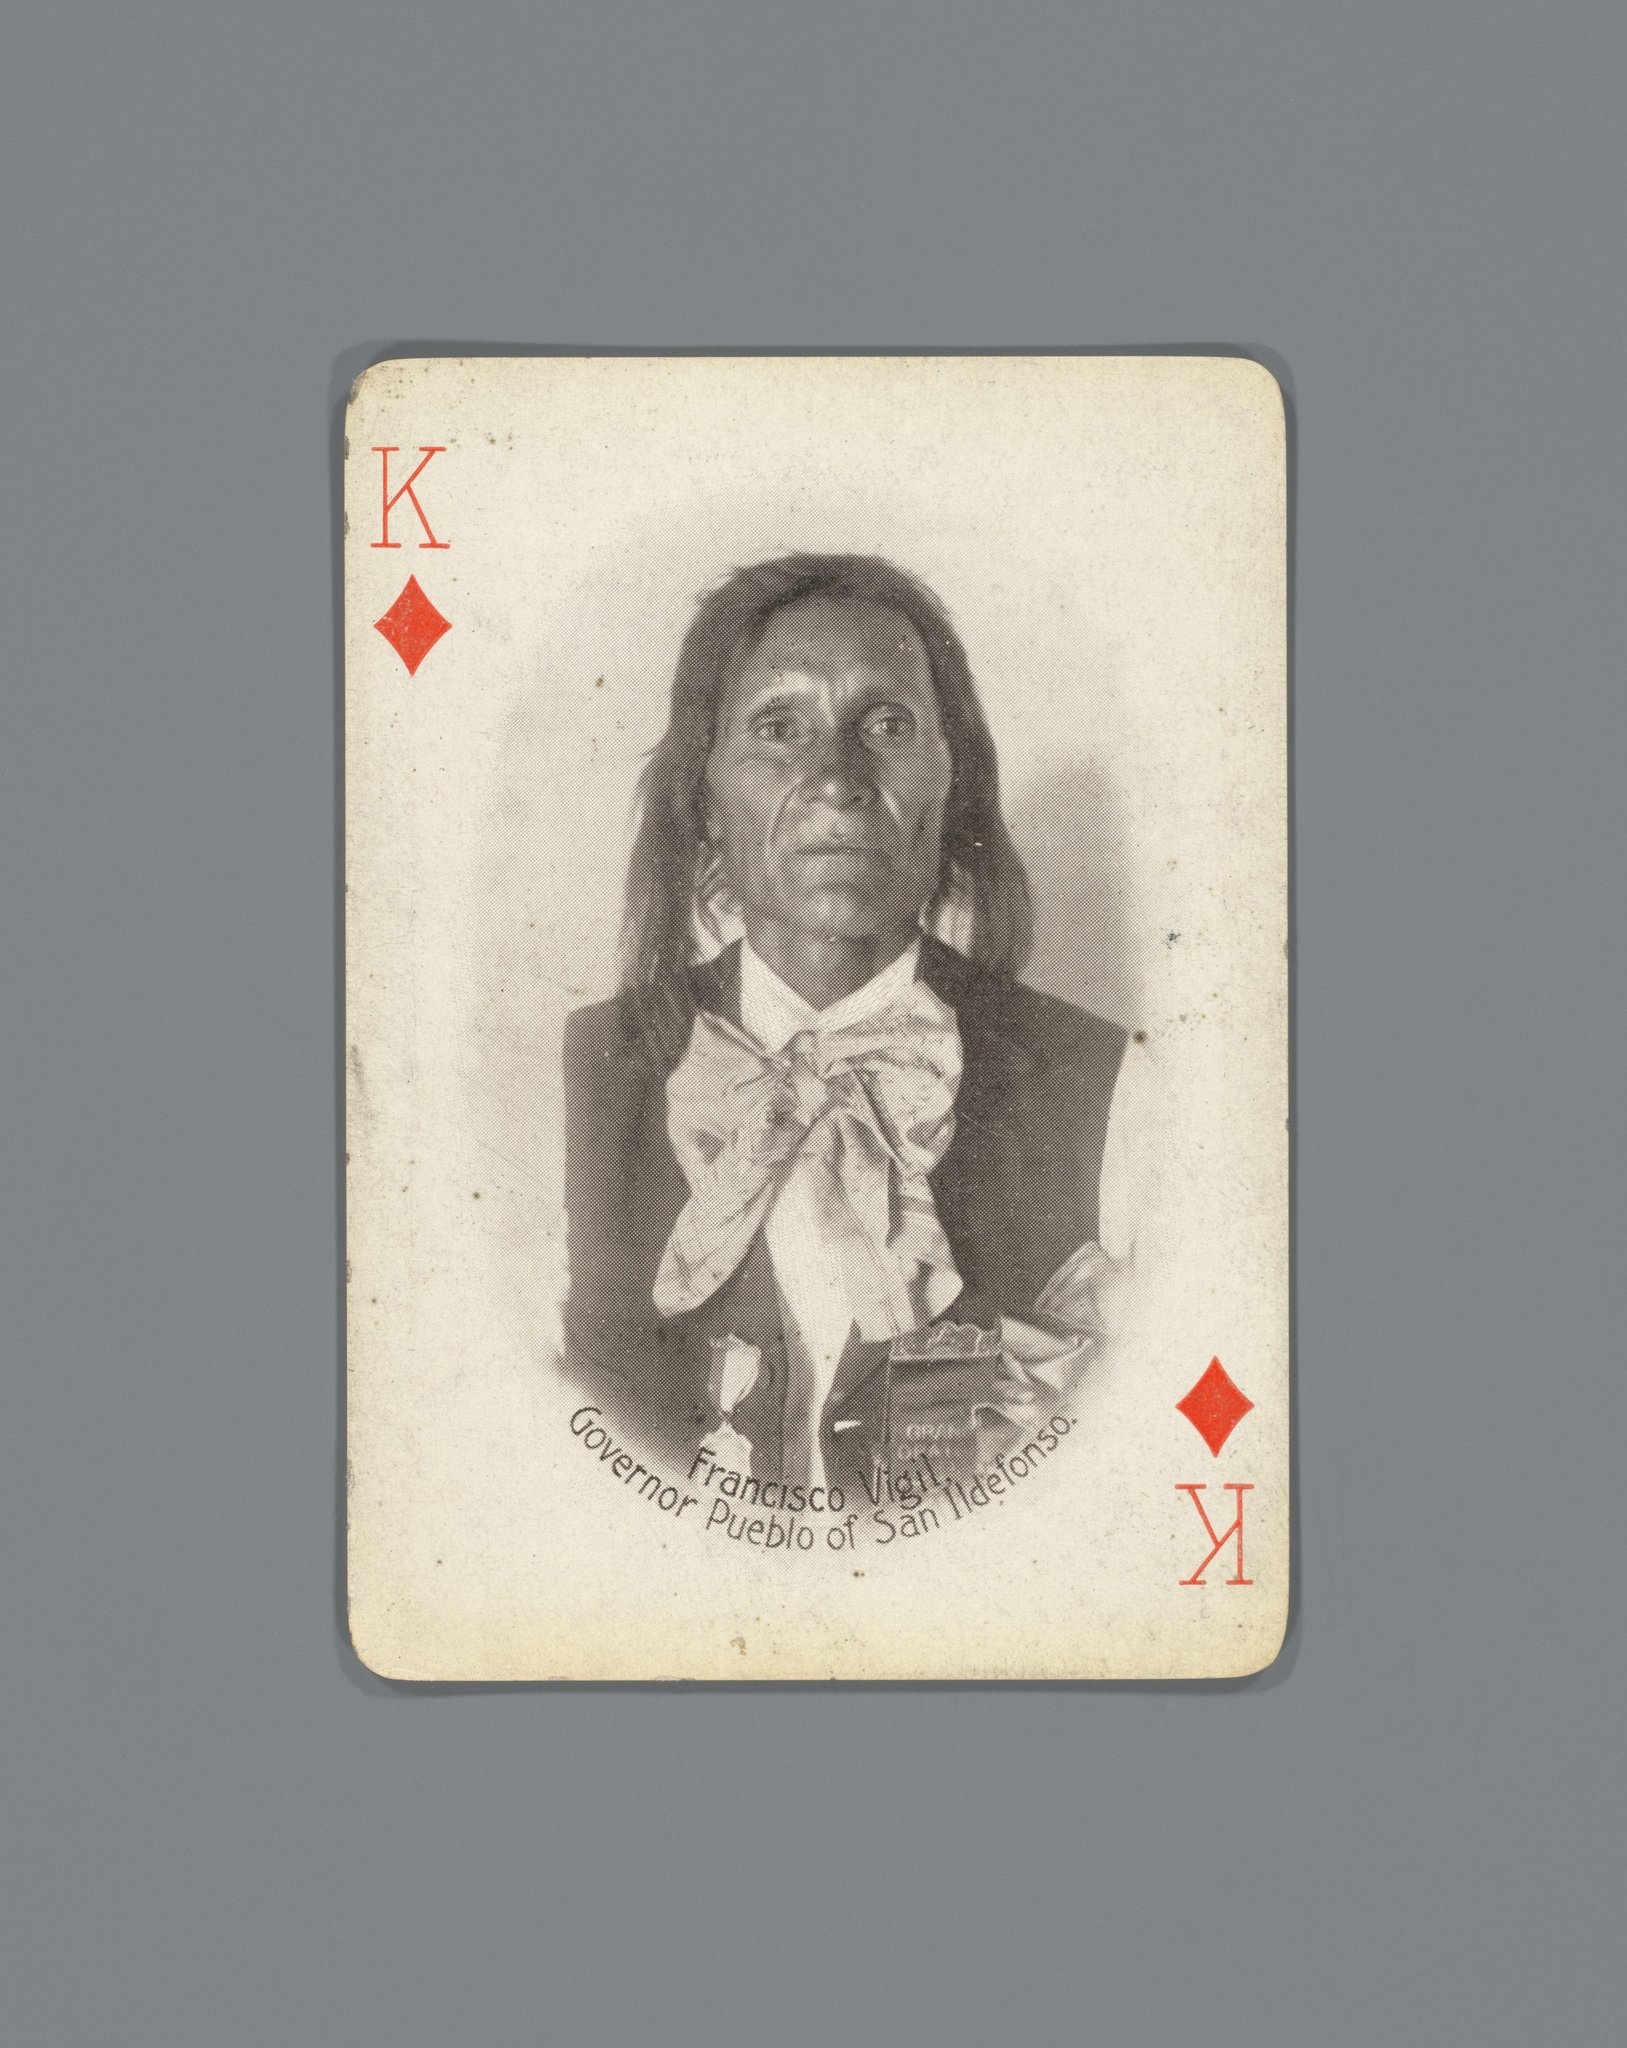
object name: photograph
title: Ruiten heer met portret van Francisco Vigil, gouverneur van San Ildefonso Pueblo, New Mexico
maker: adam clark vroman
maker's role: fotograaf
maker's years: 1856-1916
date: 1900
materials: paper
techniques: autotype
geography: los angeles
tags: new mexico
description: Speelkaart uit doosje met 53 speelkaarten met afbeeldingen in autotypie van Native Americans. De inhoud bevat een complete set speelkaarten inclusief joker.